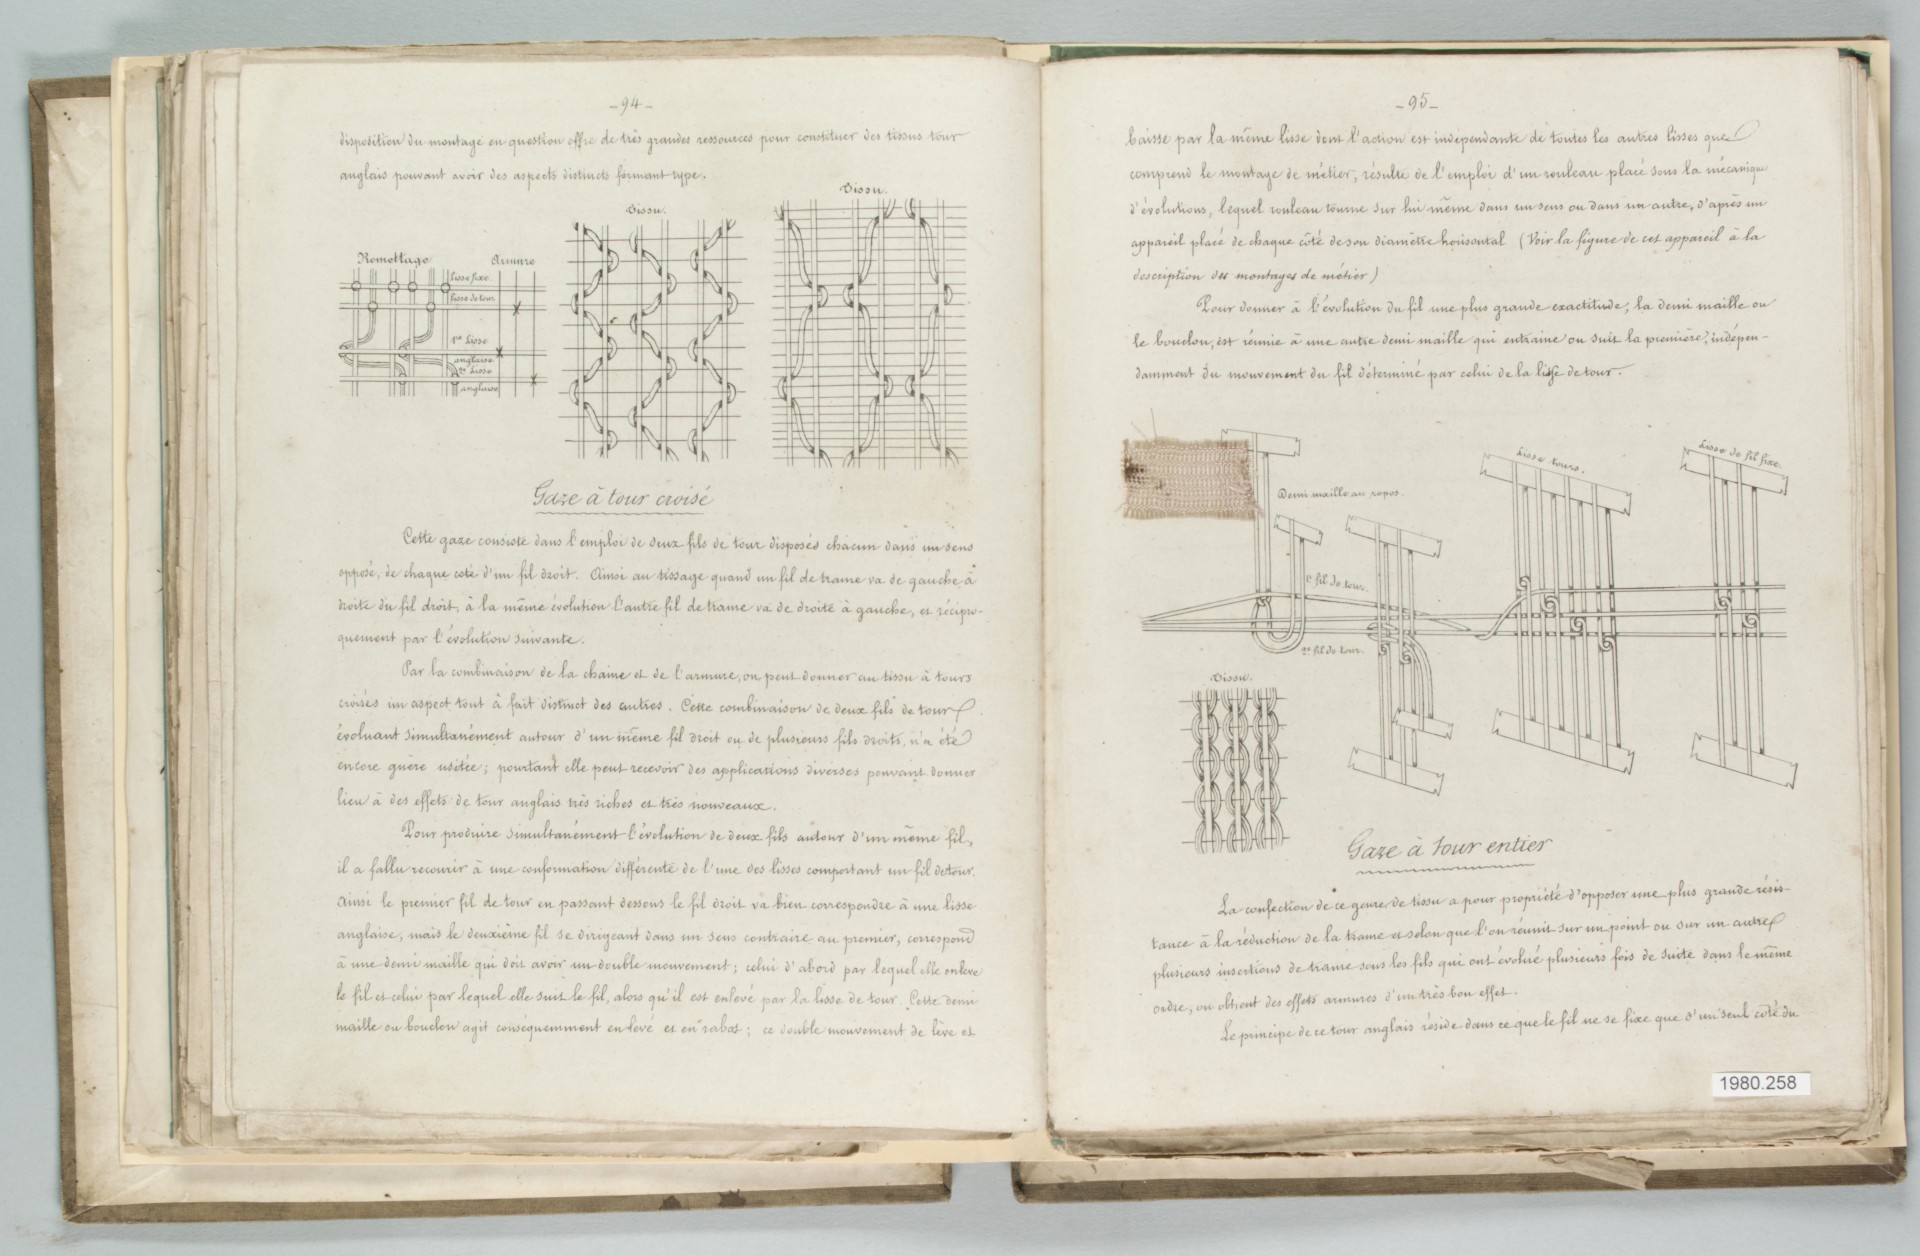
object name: book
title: Traité de la Fabrication des étoffes de soie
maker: antoine dufour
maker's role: maker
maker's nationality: french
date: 1852-1855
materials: paper